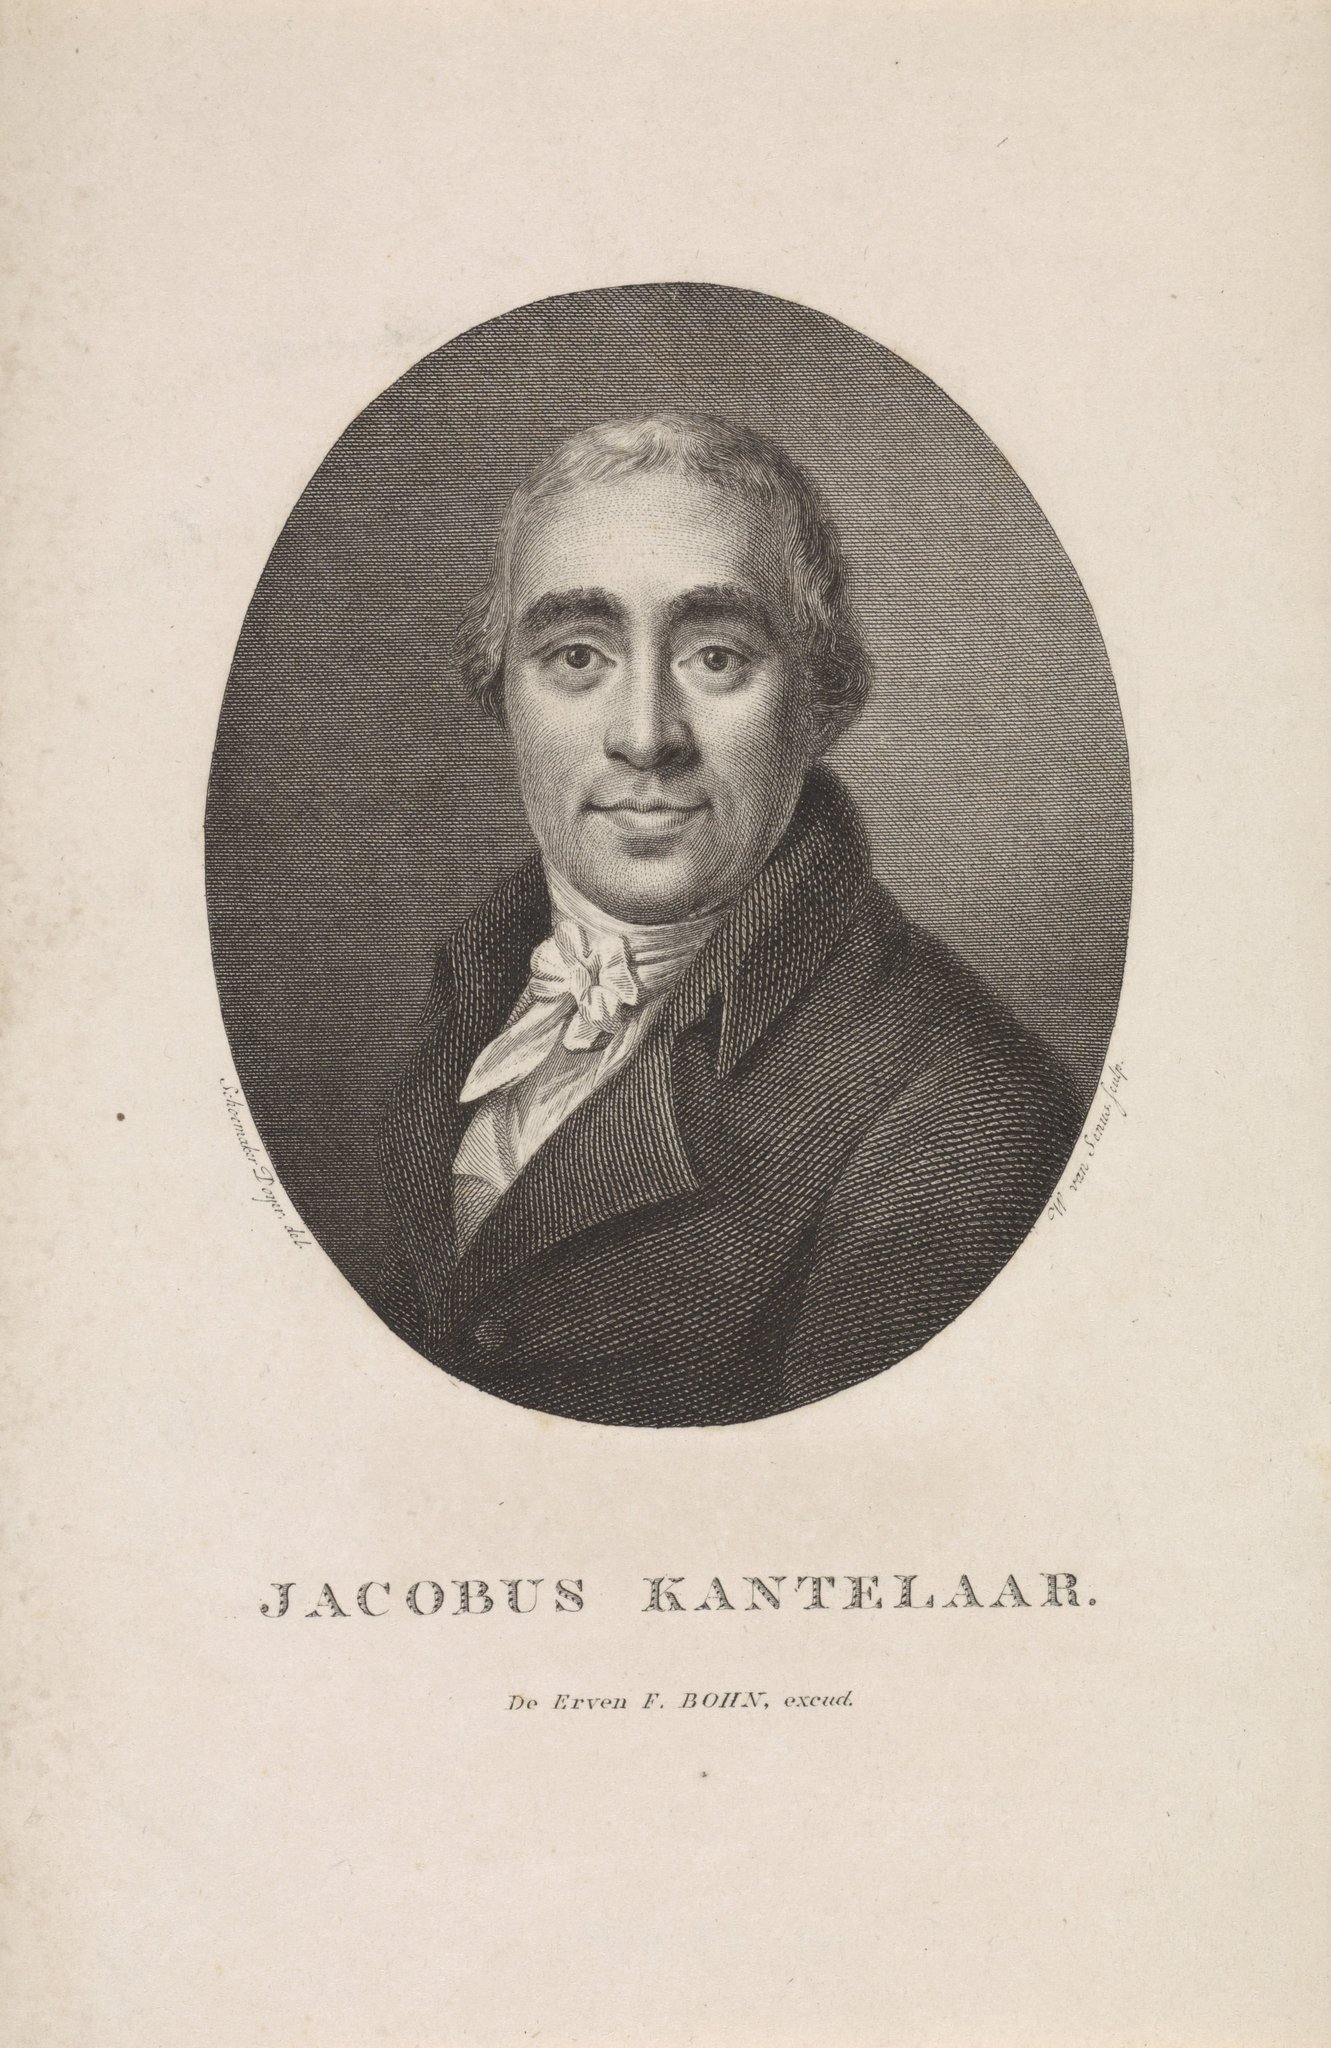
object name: print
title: Portret van Jacobus Kantelaar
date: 1812-1851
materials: paper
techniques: engraving, etching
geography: haarlem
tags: amsterdam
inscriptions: collector's mark: Lugt 2228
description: Portret van de predikant en letterkundige Jacobus Kantelaar.